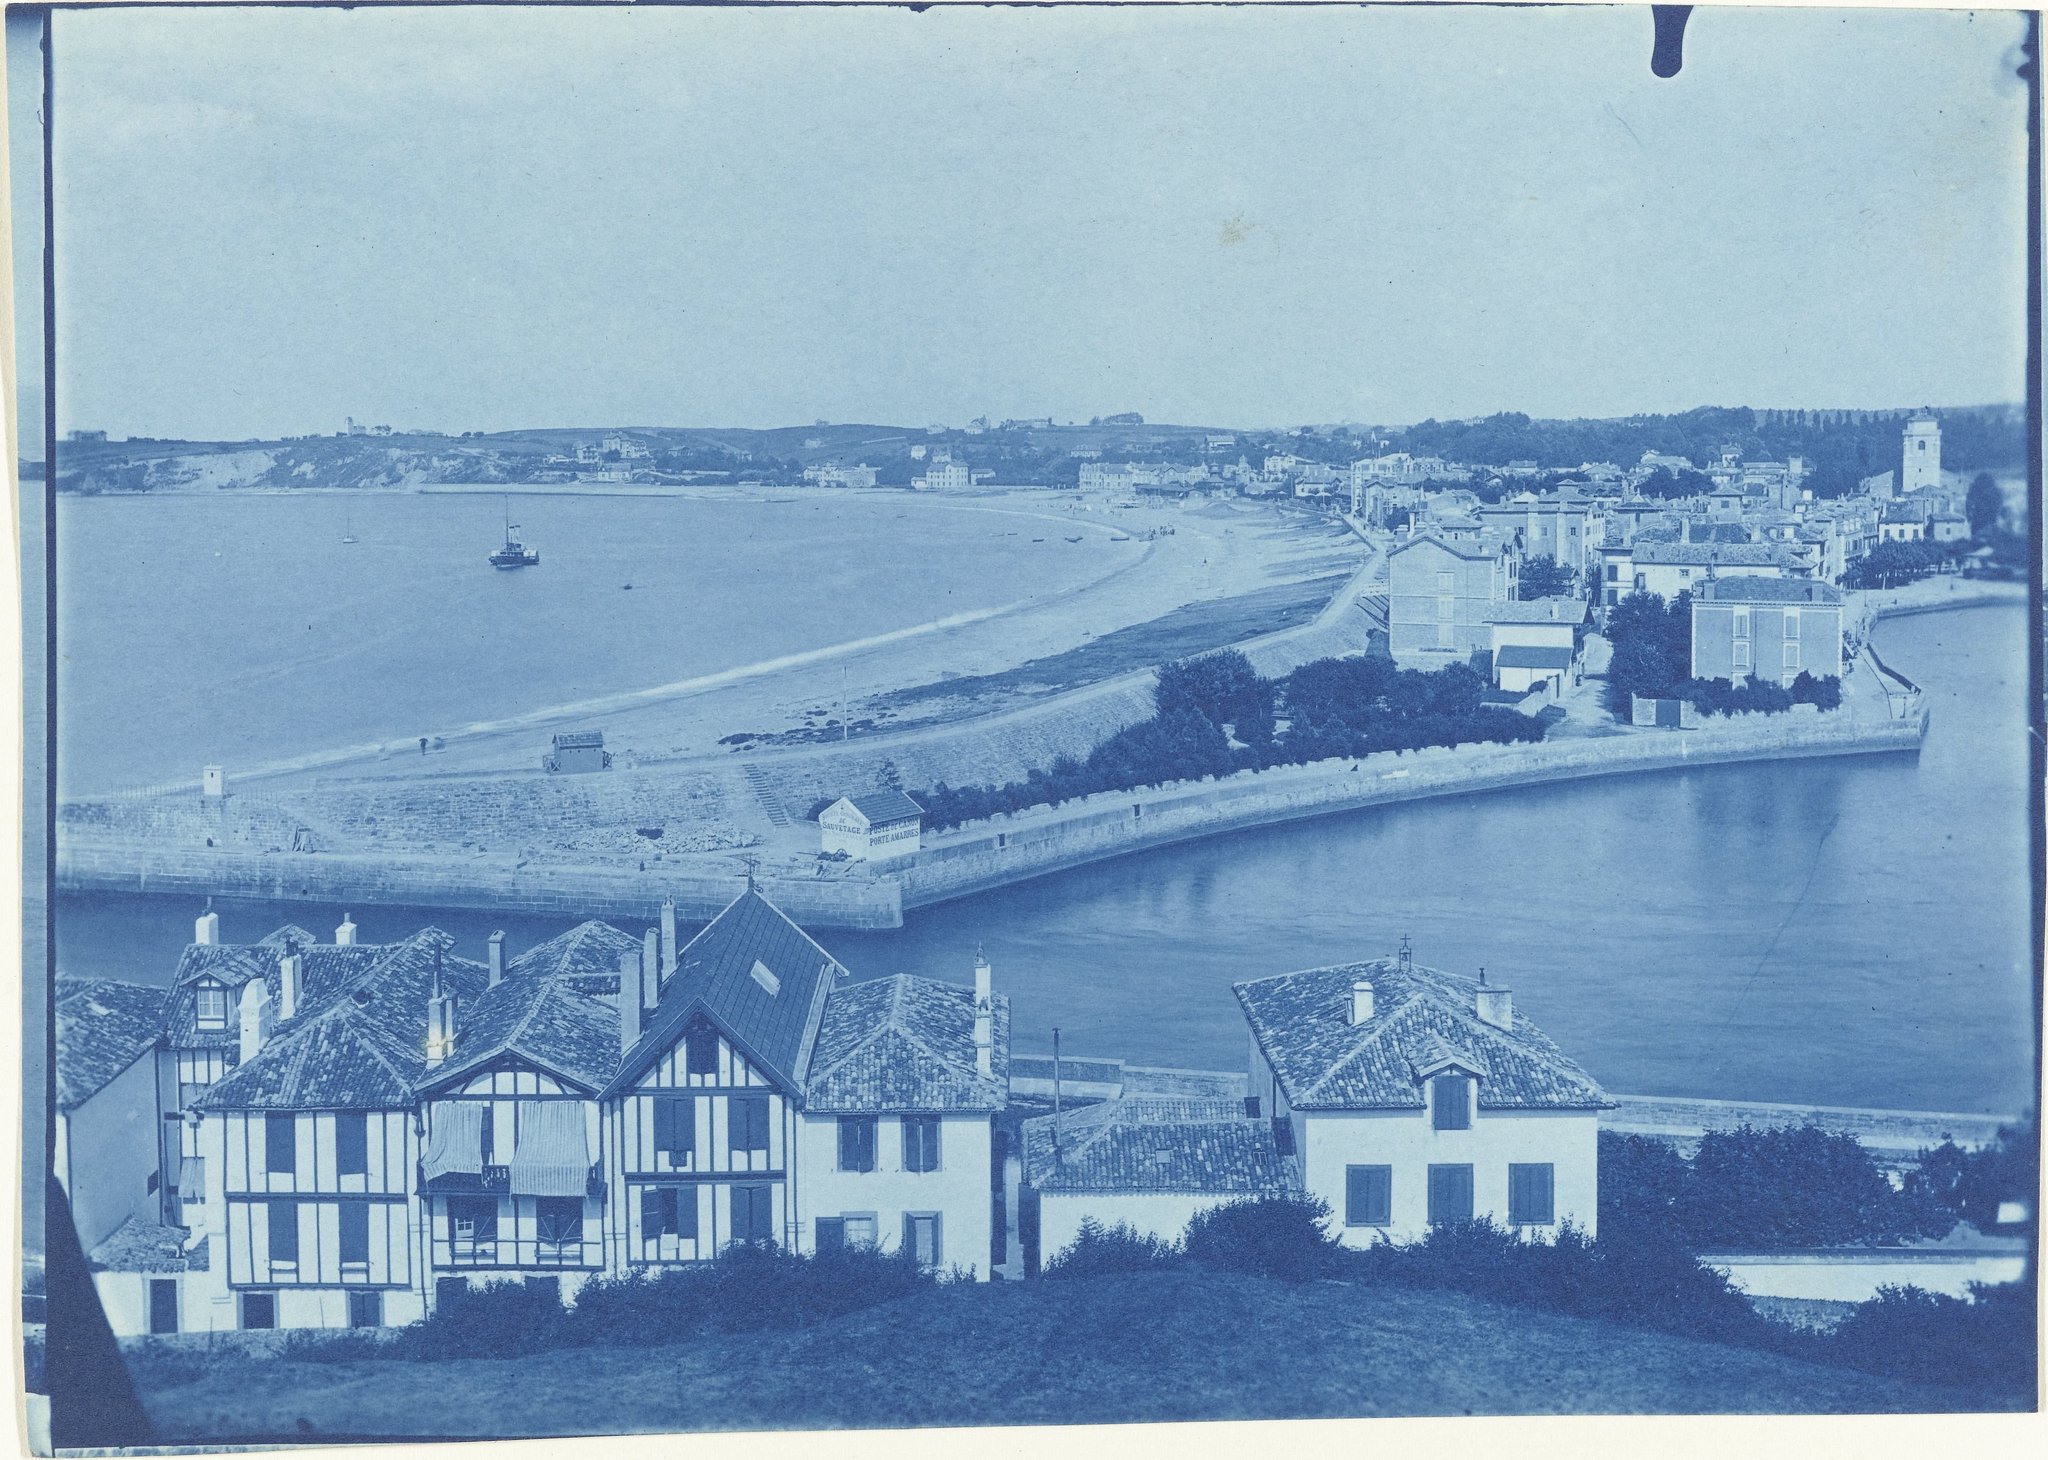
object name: photograph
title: Gezicht op Saint-Jean-de-Luz, Frankrijk, gezien vanaf Sainte-Barbe, met links de baai van de Atlantische Oceaan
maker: Anonymous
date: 1890-1920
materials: paper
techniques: cyanotype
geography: saint-jean-de-luz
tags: gulf, bay, prospect of village, silhouette of village, atlantic ocean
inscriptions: inscription: ‘St. Jean de Luz pris de St. [?] Barbe’